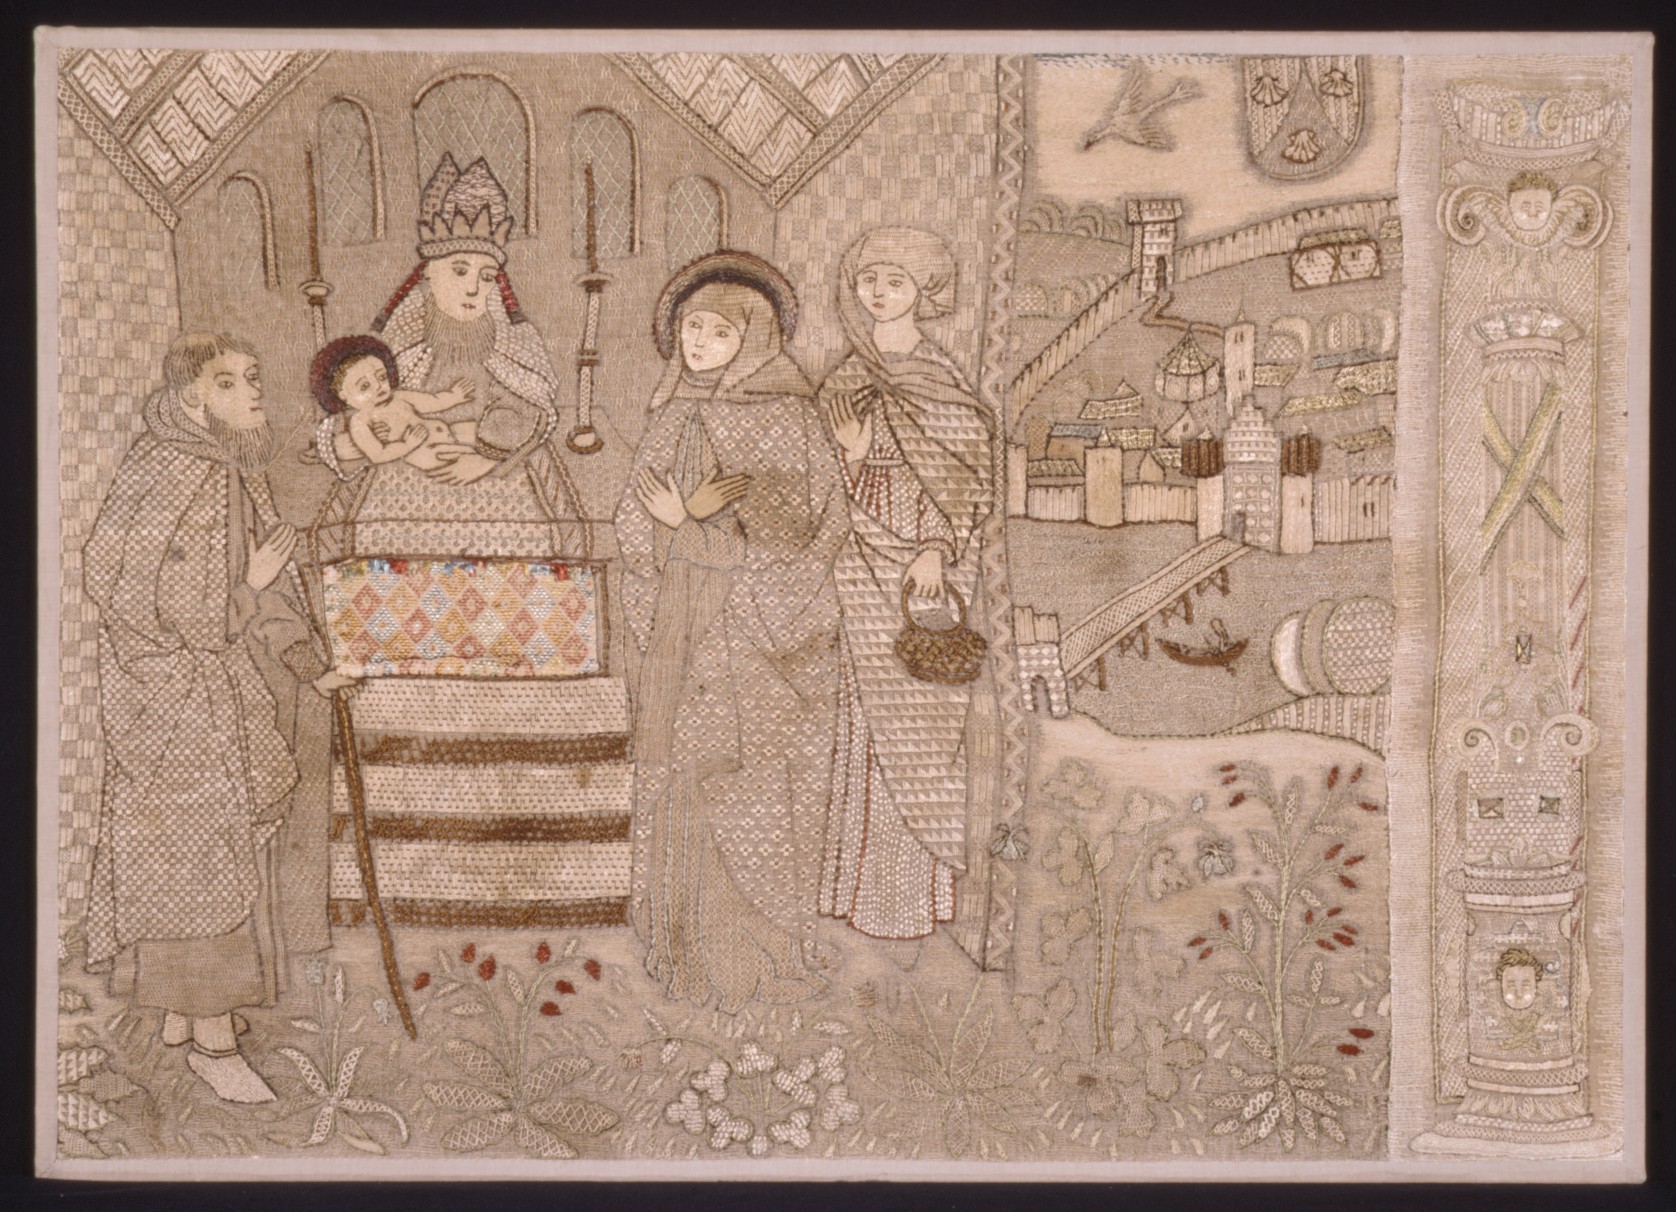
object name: textile orphrey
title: The Presentation in the Temple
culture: spanish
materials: linen, metal, silk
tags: men,virgin mary,jesus